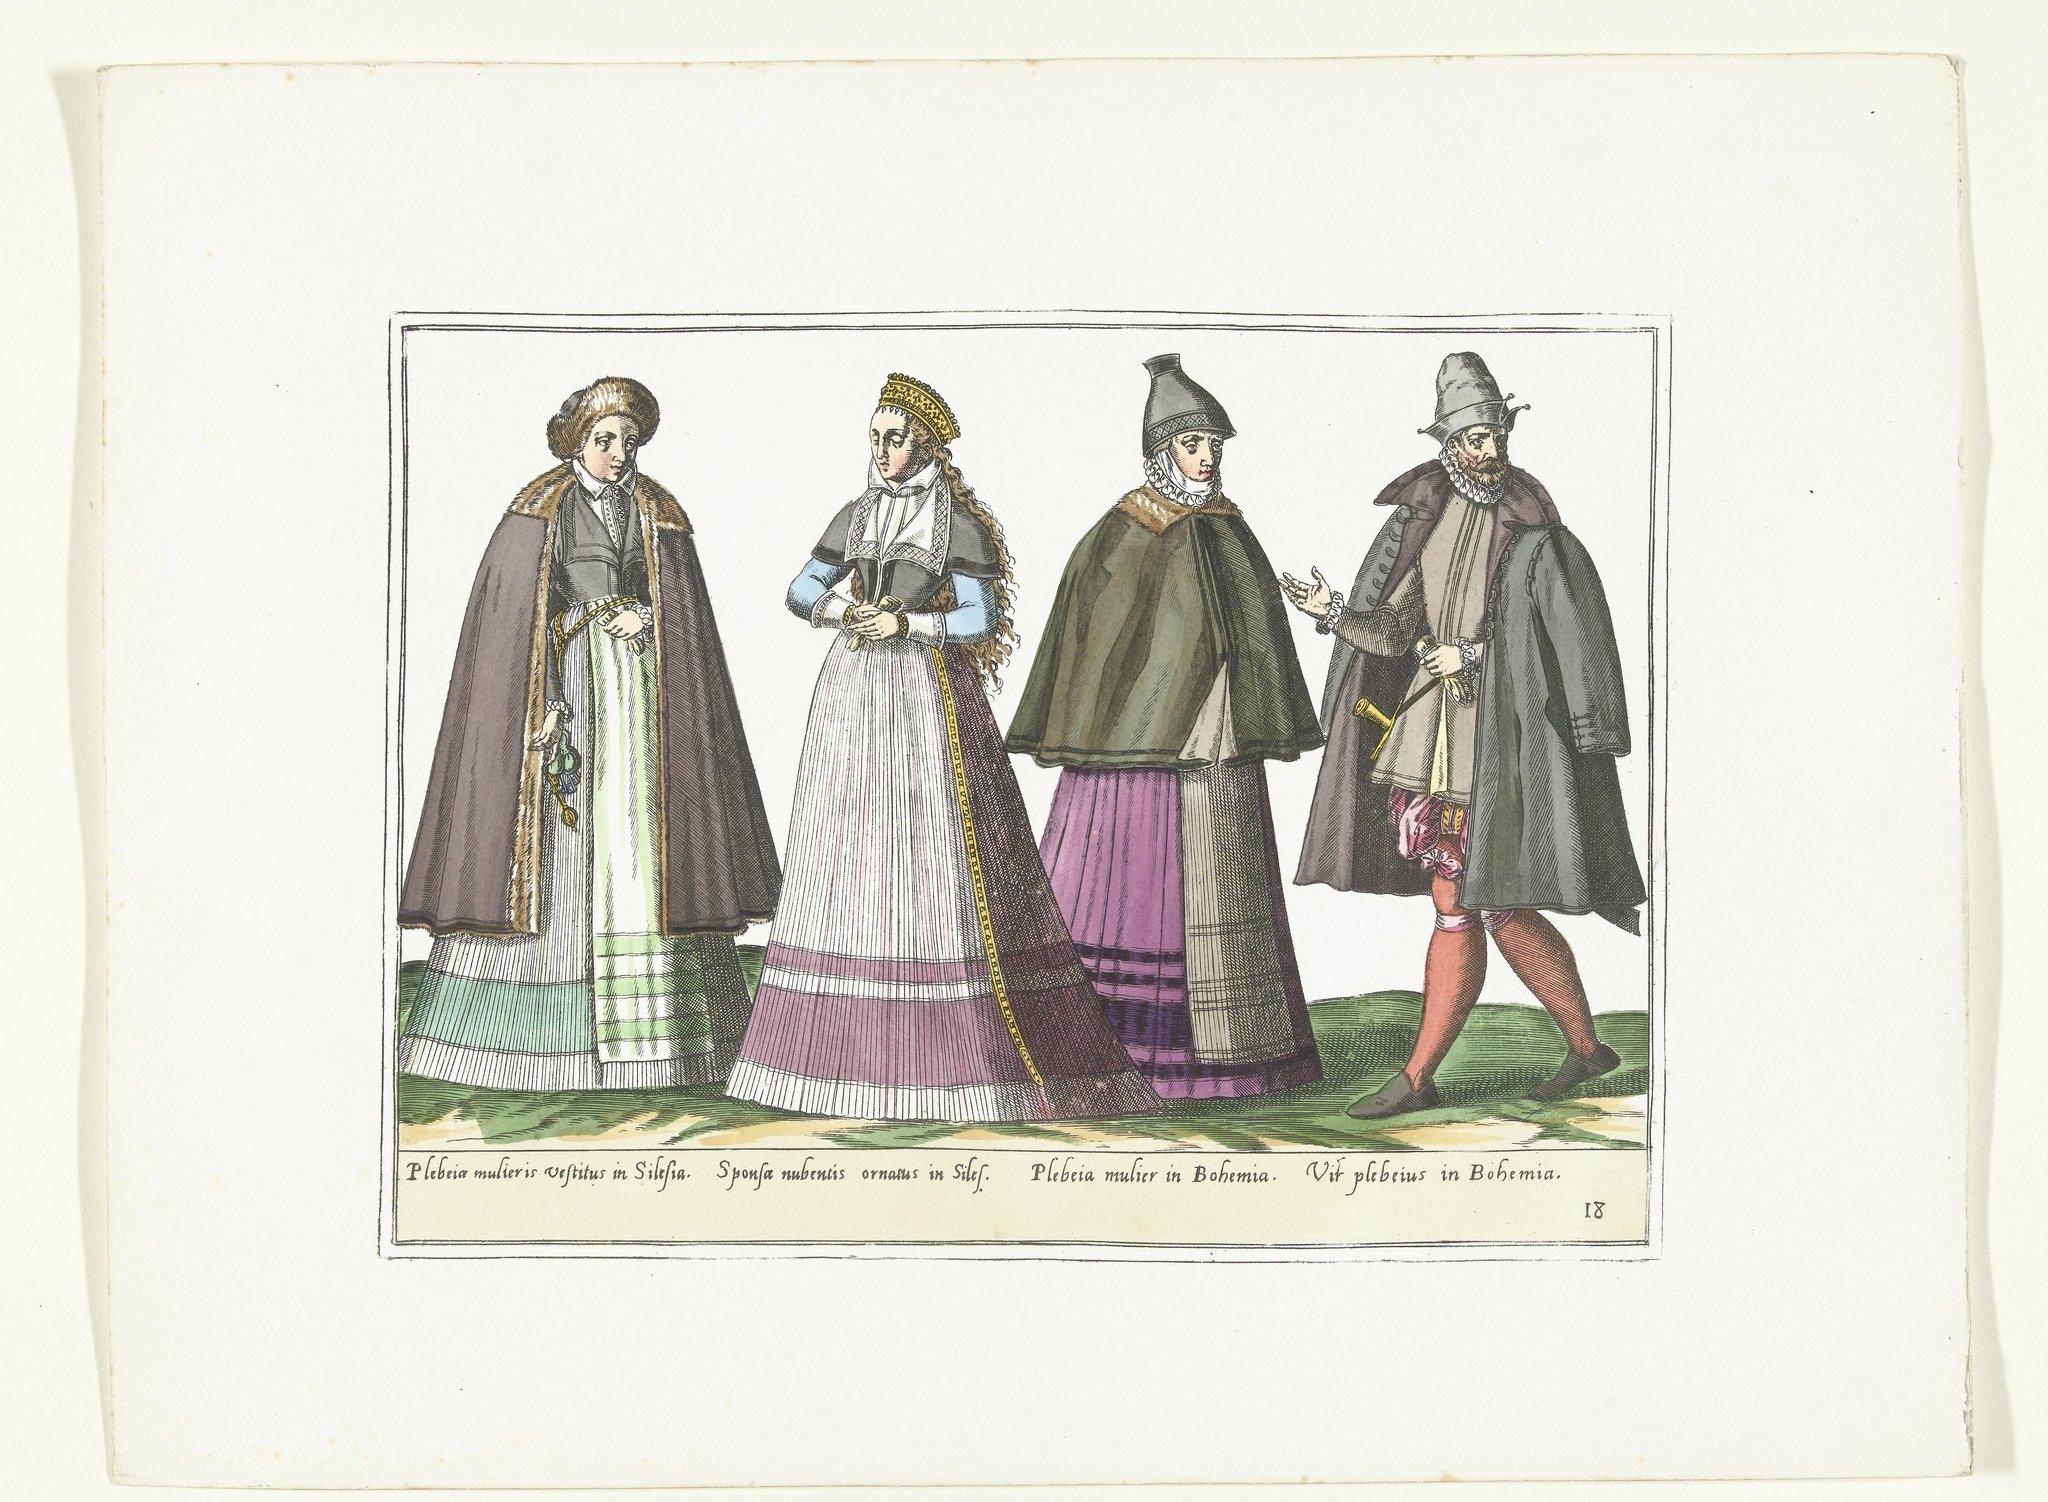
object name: facsimile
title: Drie vrouwen en een man gekleed volgens de Duitse mode, ca. 1580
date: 1872-1875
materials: paper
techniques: hand coloring, printing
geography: brussels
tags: cape (+ men's clothes), cape (+ women's clothes), head-gear: hat (+ men's clothes), clothes, costume (+ women's clothes), head-gear: hat (+ women's clothes), dress, gown (+ women's clothes), clothes, costume (+ men's clothes), trousers, breeches, etc. (breeches) (+ men's clothes), clothing for the upper part of the body (doublet) (+ men's clothes), germany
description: Onderdeel van Costumes civils et militaires du XVIe siècle par A. de Bruyn, een selectie van prenten uit de Trachtenbuch van Abraham de Bruyn uit 1581 (Hollstein 248-306), in facsimile. Losbladig uitgegeven met titelbladen, verklaring en lijst van de platen door G.A. van Trigt te Brussel in 1875 met teksten van Auguste Schoy. In de Rijksmuseum Research Library met signatuur 34 C 43.